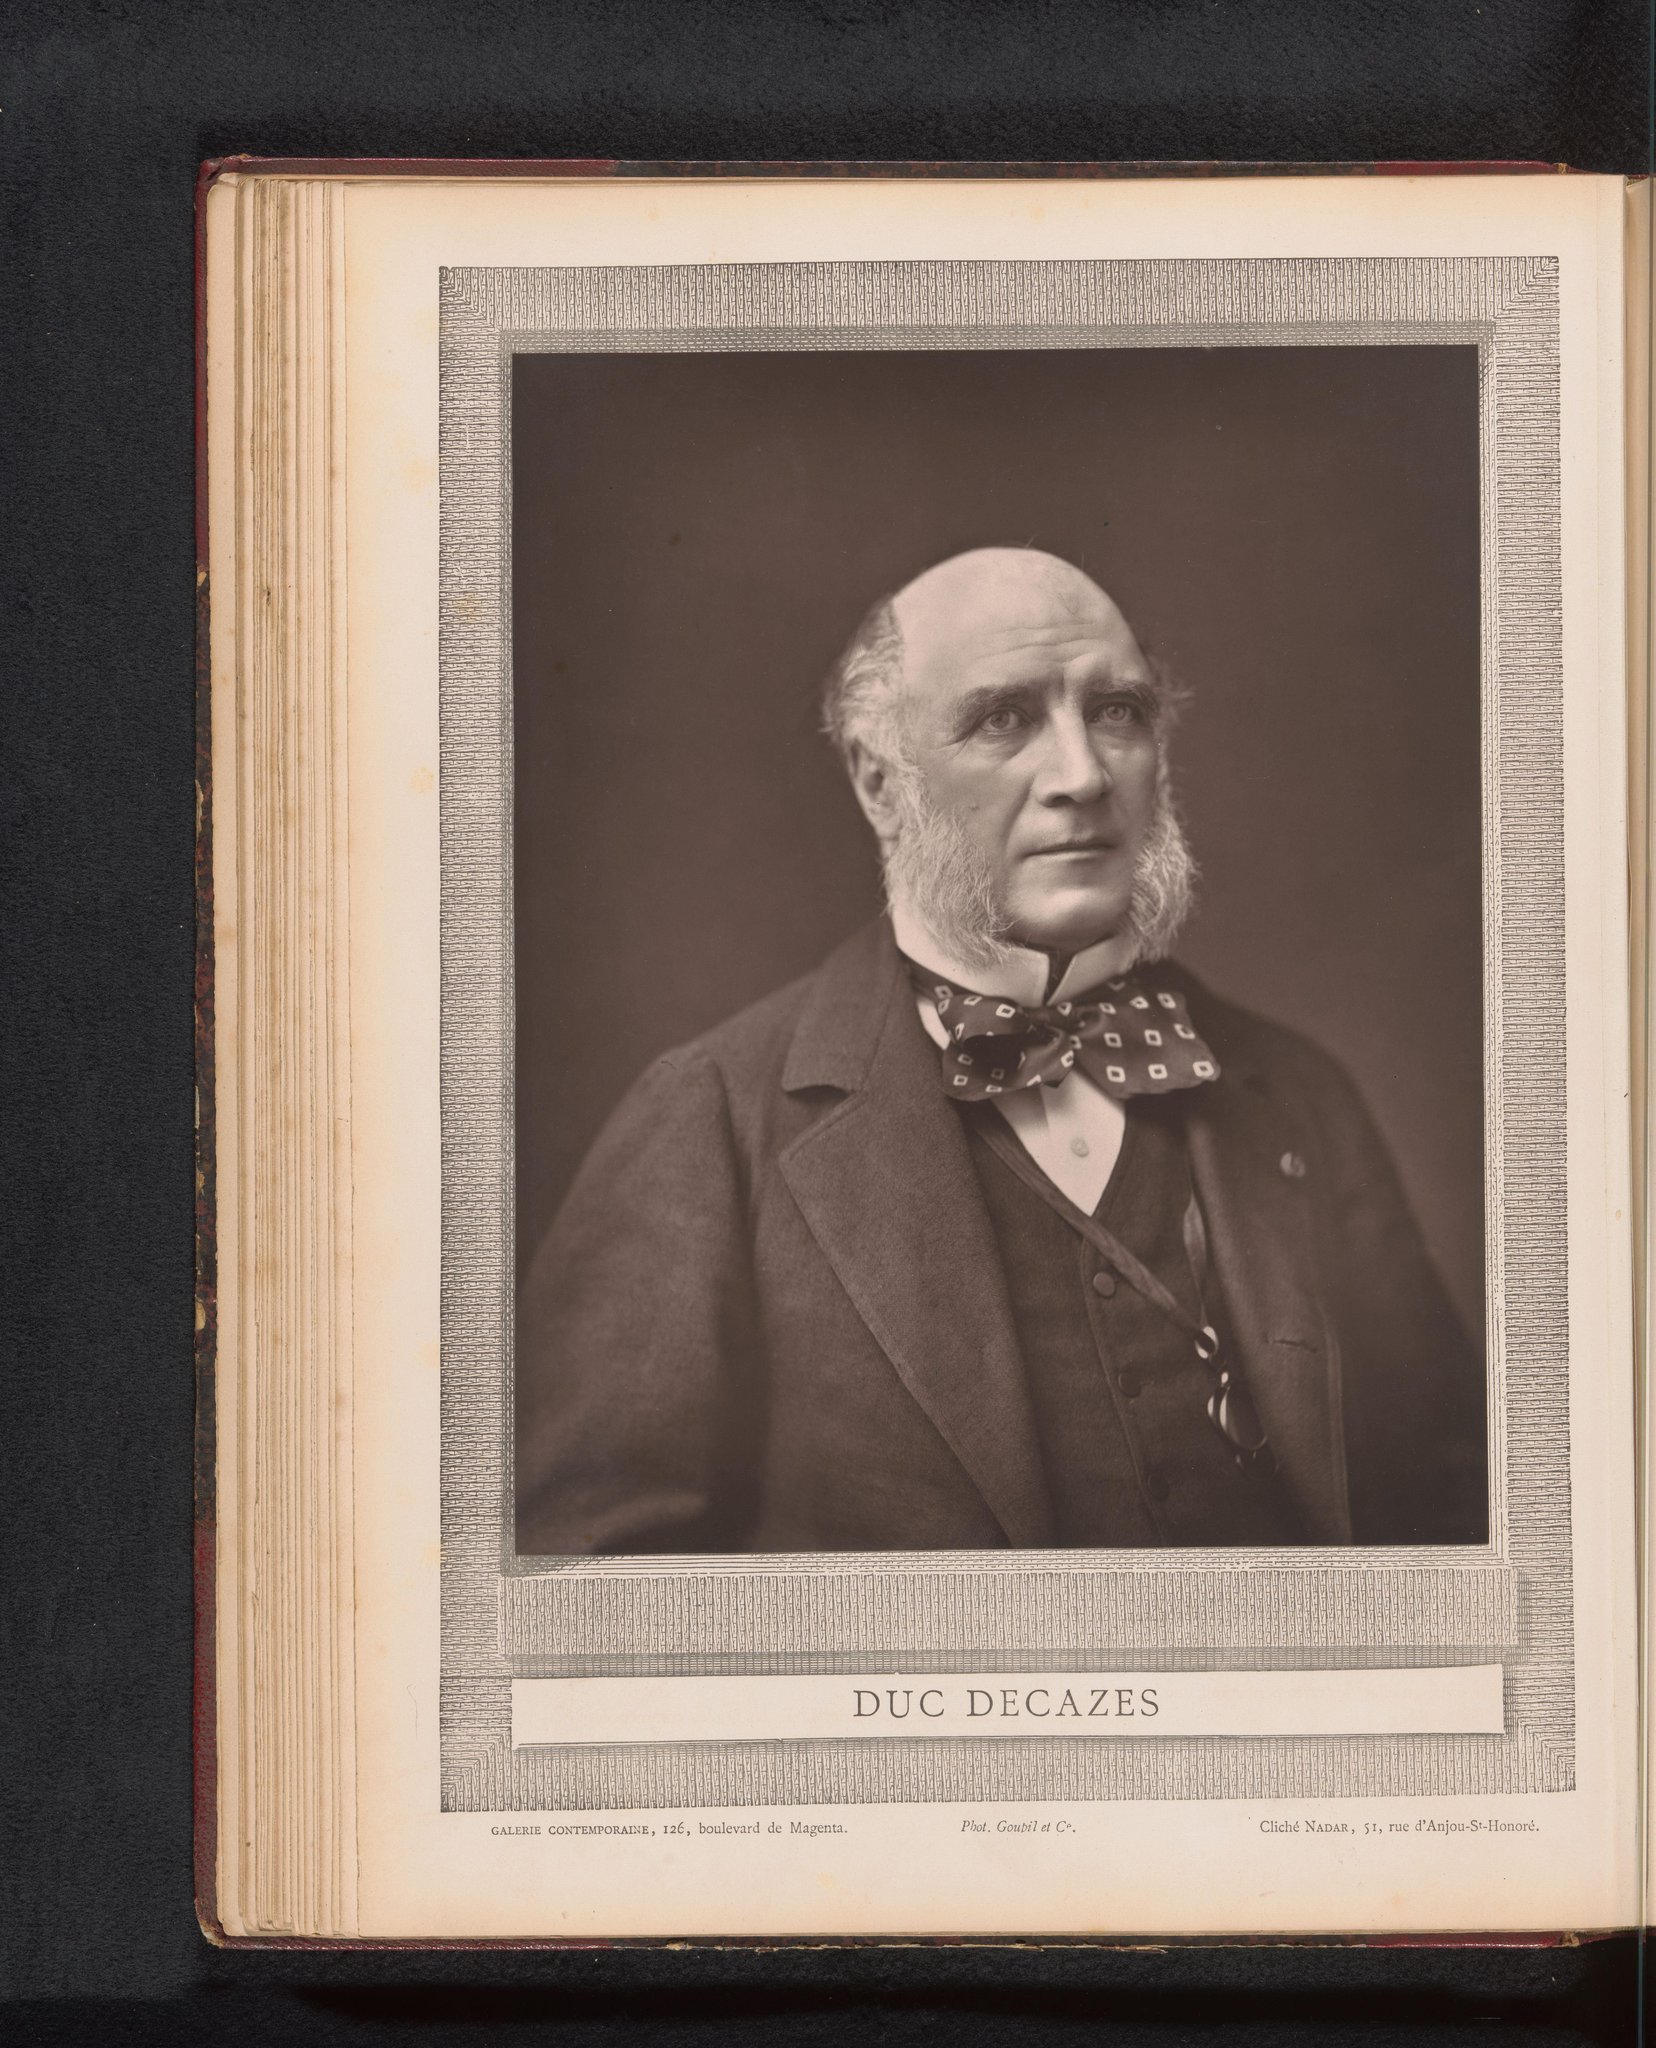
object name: page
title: Portret van Louis Decazes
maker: félix nadar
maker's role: ballonvaarder, fotograaf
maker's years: 1820-1910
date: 1872-1877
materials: paper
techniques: woodburytype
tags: adult man, historical persons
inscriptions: inscription: ‘Galerie Contemporaine, 126, boulevard de Magenta.’